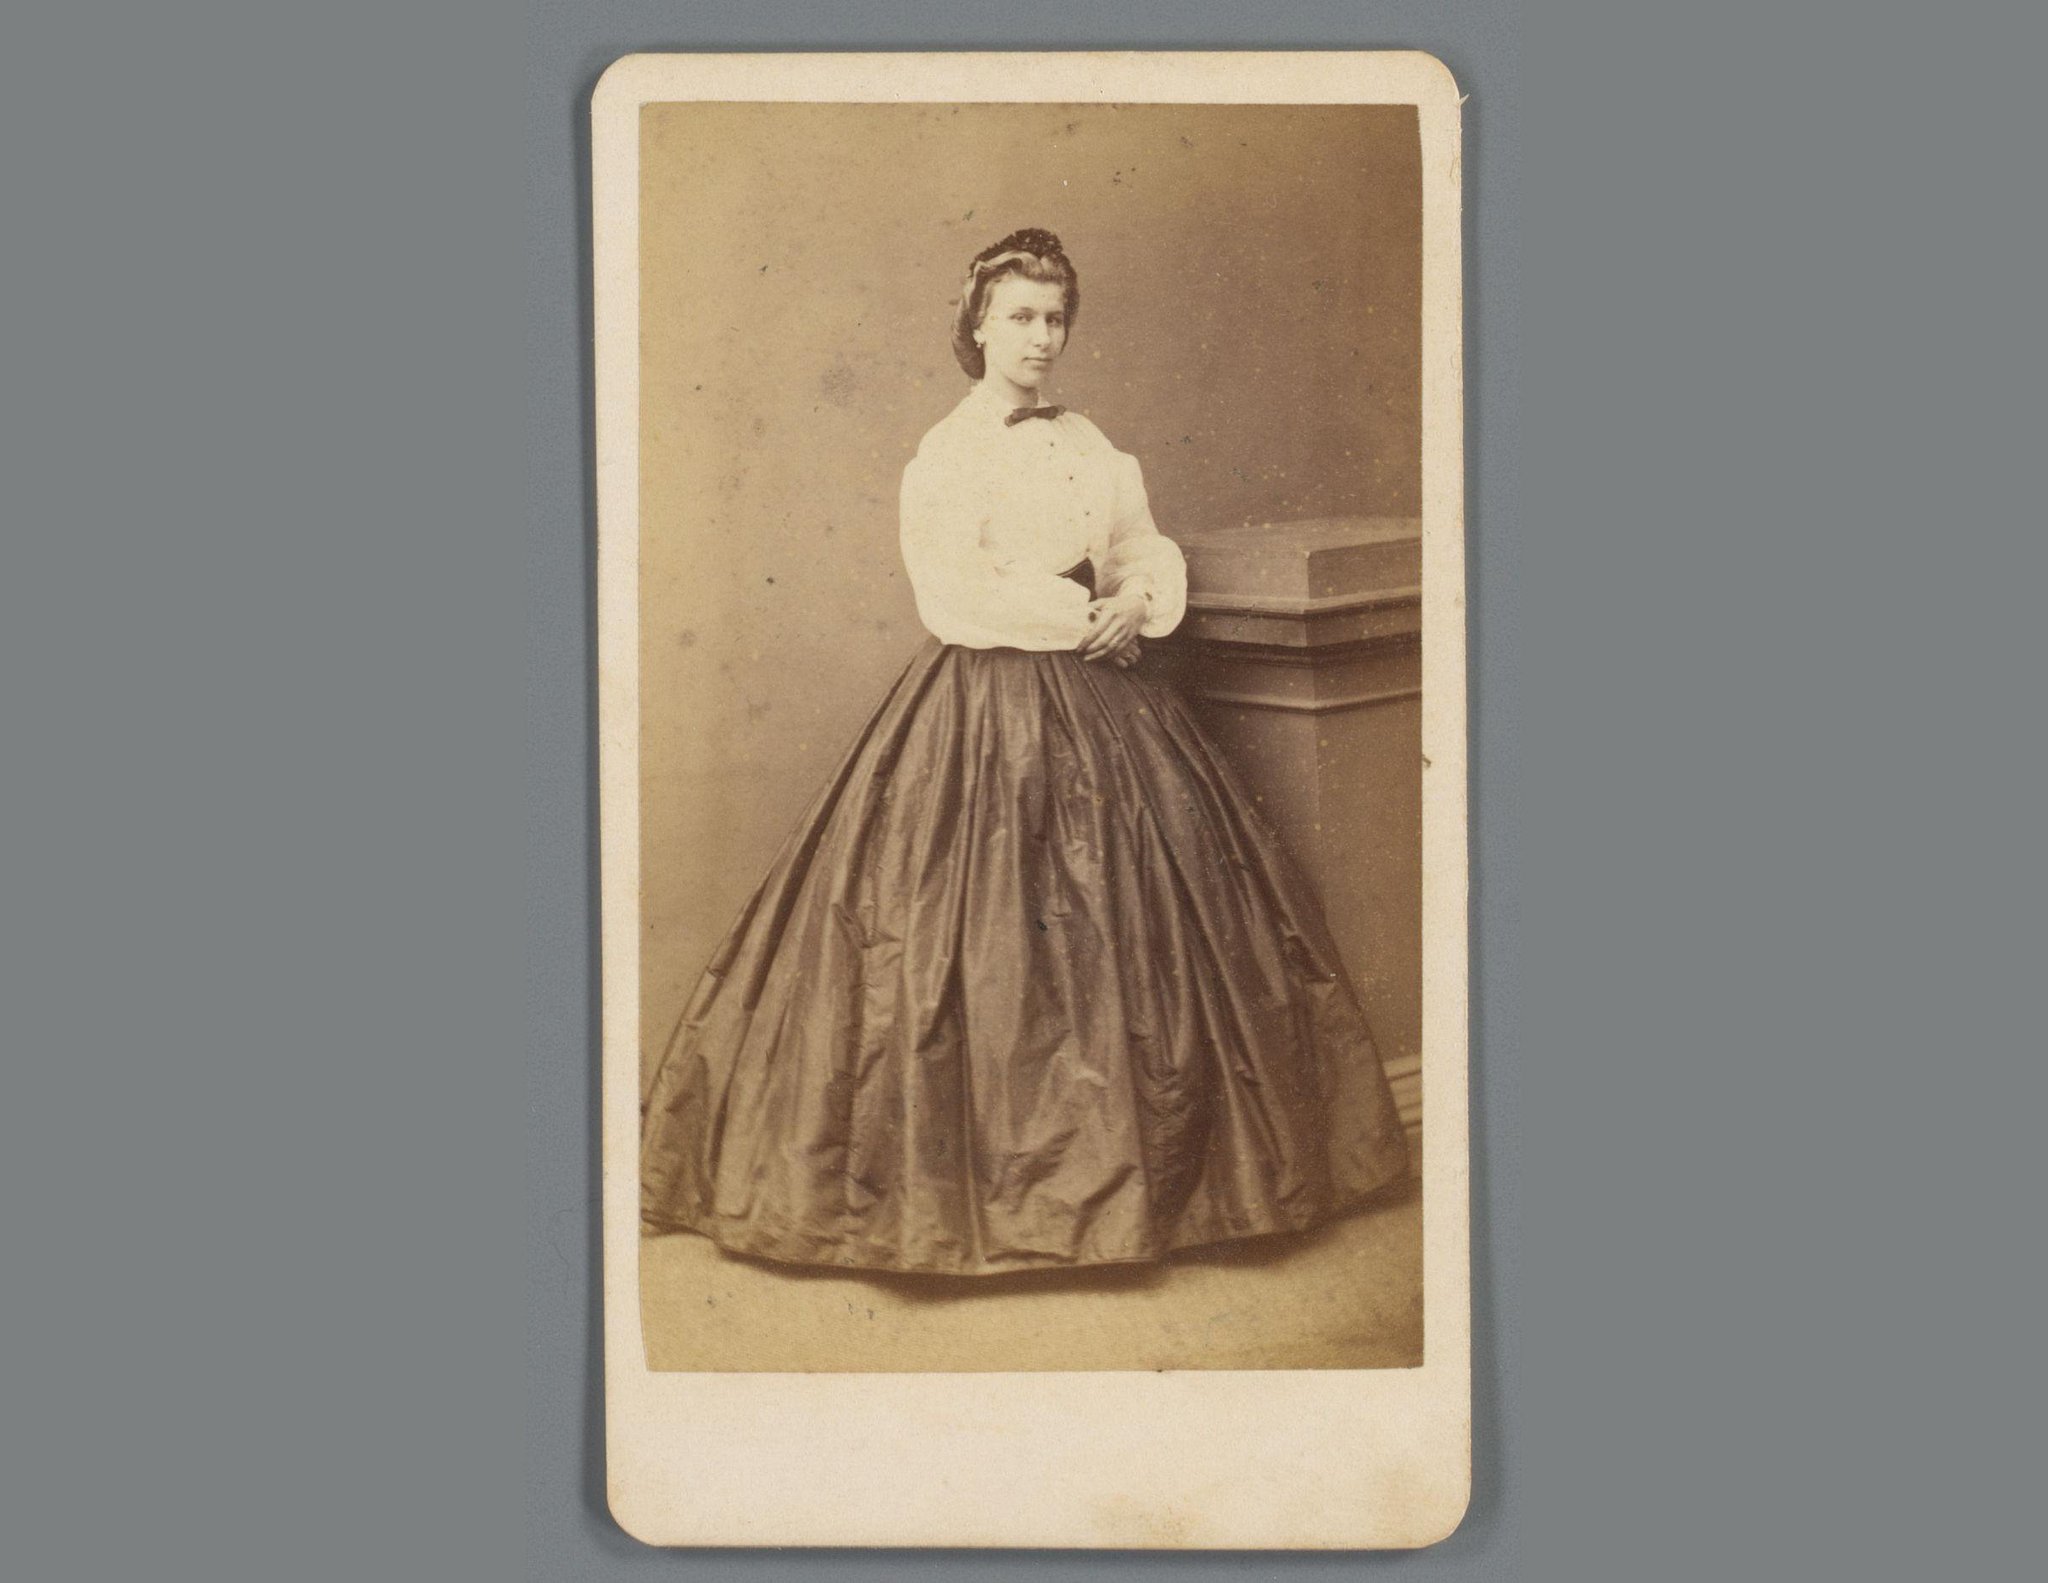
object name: carte de visite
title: Portret van een onbekende vrouw uit de familie en de kring van Eugene van Delden en Belle van Delden-Denninghof Stelling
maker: matthijs adolph conen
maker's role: painter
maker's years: 1833-1894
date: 1862-1870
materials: cardboard, paper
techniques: albumen print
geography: amsterdam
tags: historical persons not known by name - bb - woman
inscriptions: inscription: ‘ADOLPHE CONEN/ PEINTRE-PHOTOGRAPHE/ AMSTERDAM/ Plantage Middenlaan, V. 132’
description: Portret uit de kring van Eugene van Delden (Hartapoera, 1865 - Den Haag, 1954) en Belle van Delden-Denninghof Stelling (Batavia, 1870 - Den Haag, 1947).